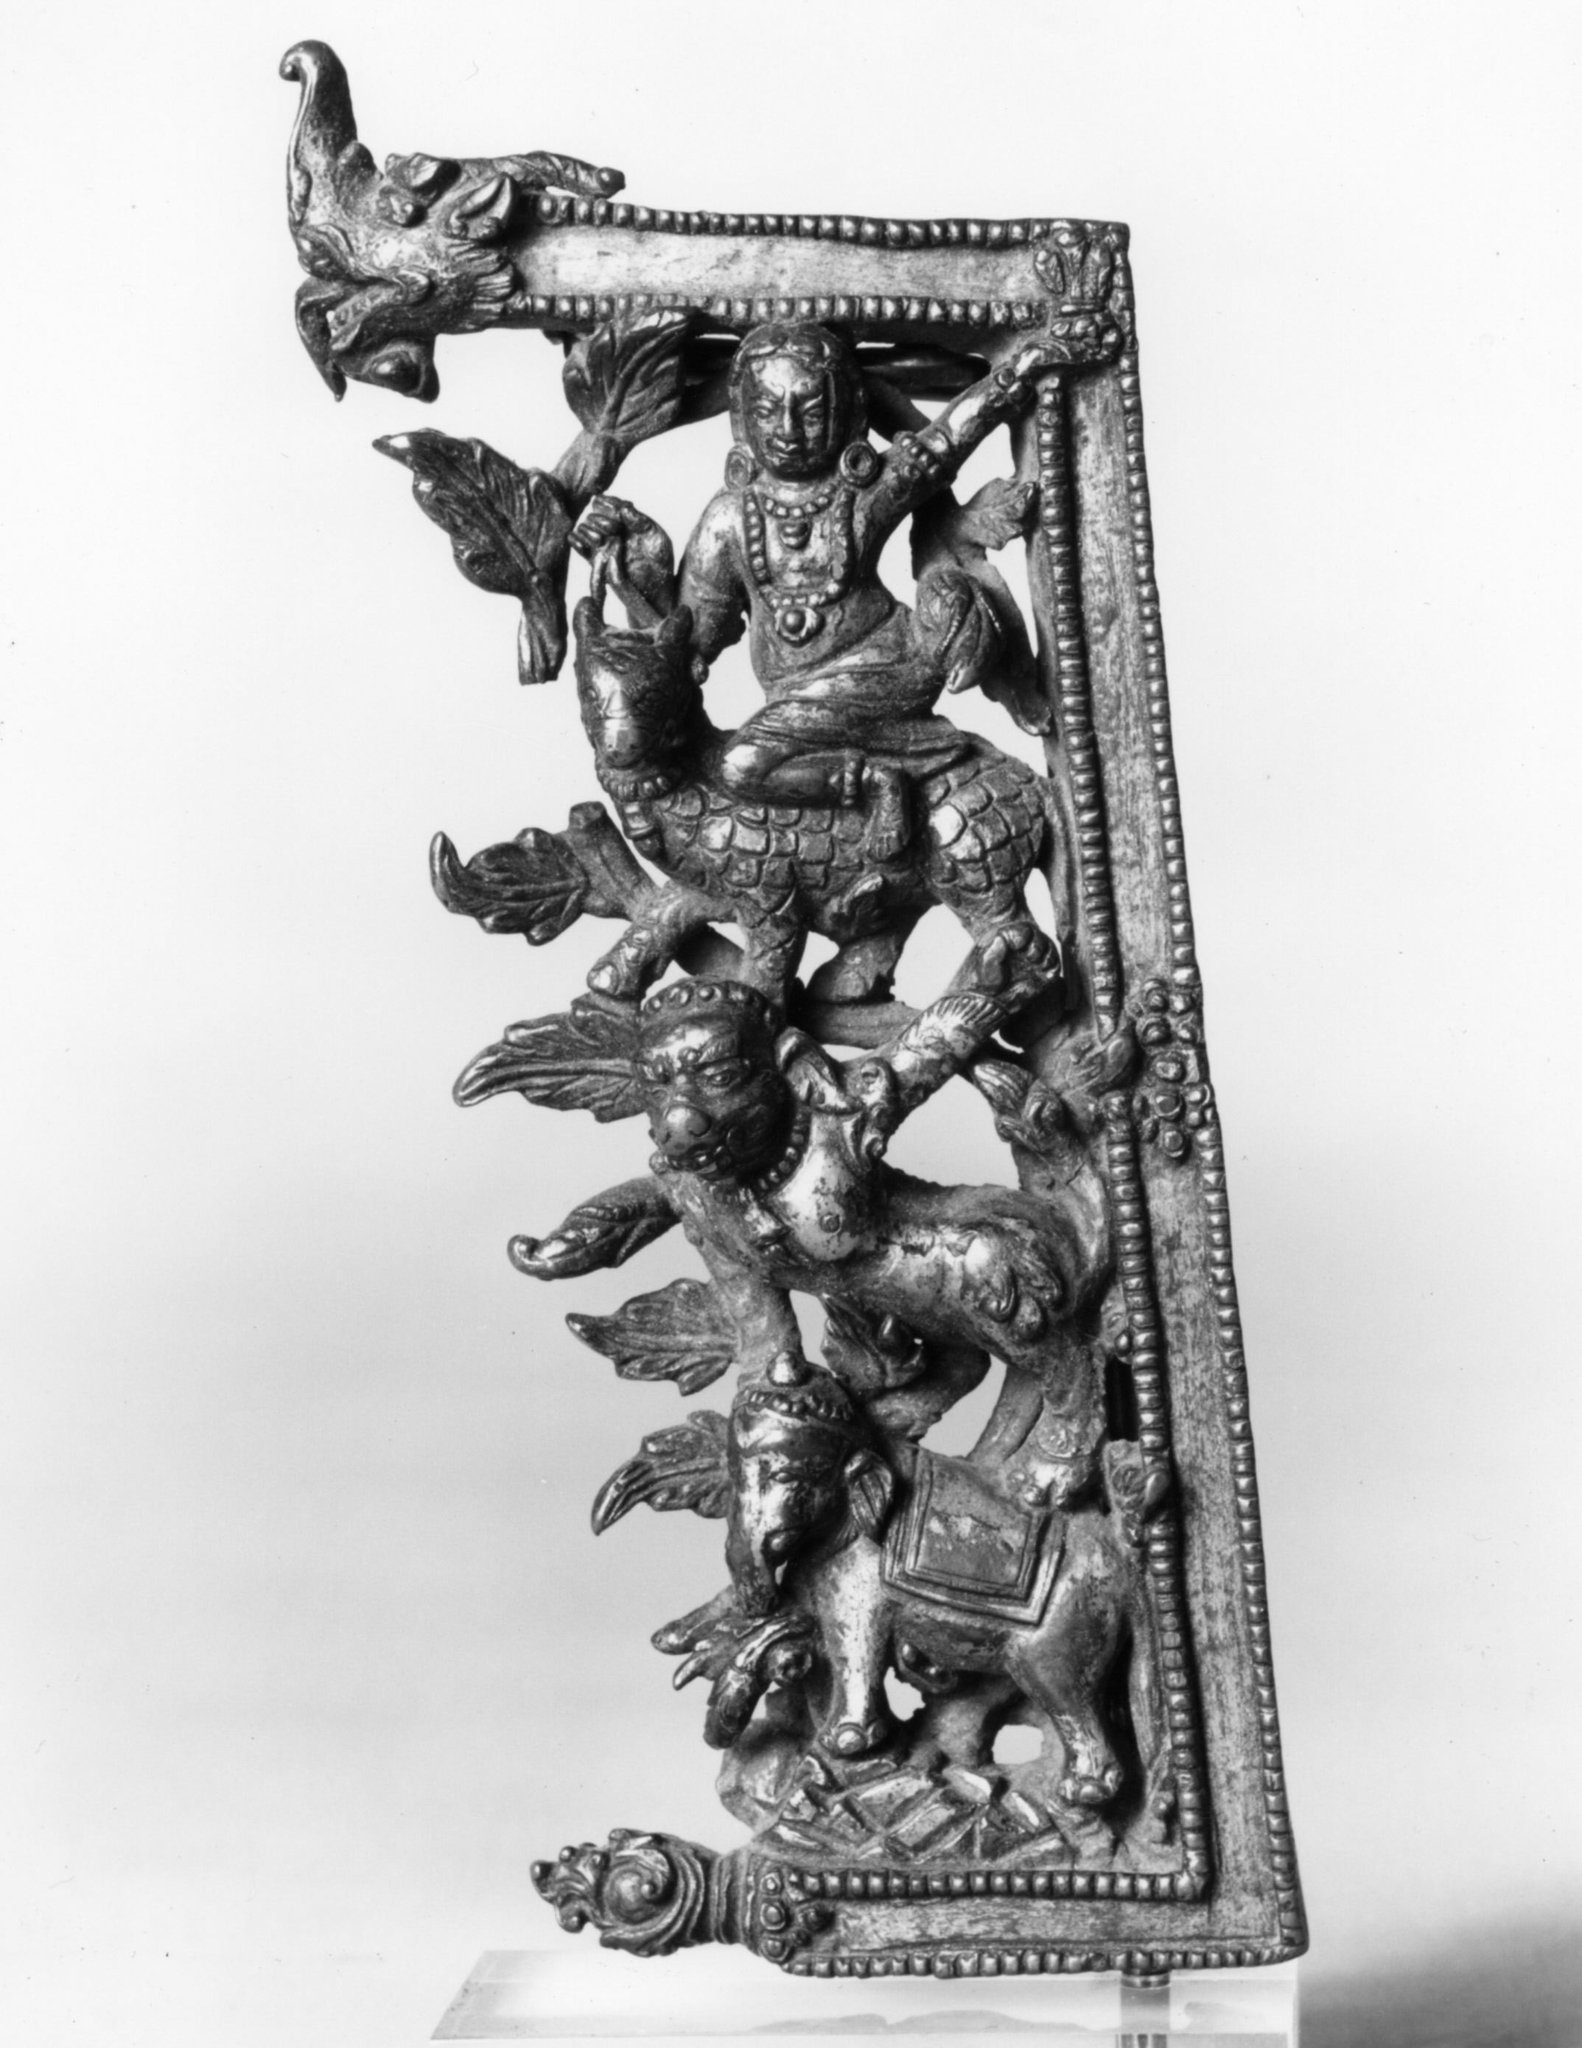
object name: fragment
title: Fragment from the Backplate of an Icon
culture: nepali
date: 1501-1600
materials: copper alloy, gilt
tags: animals,men,elephants